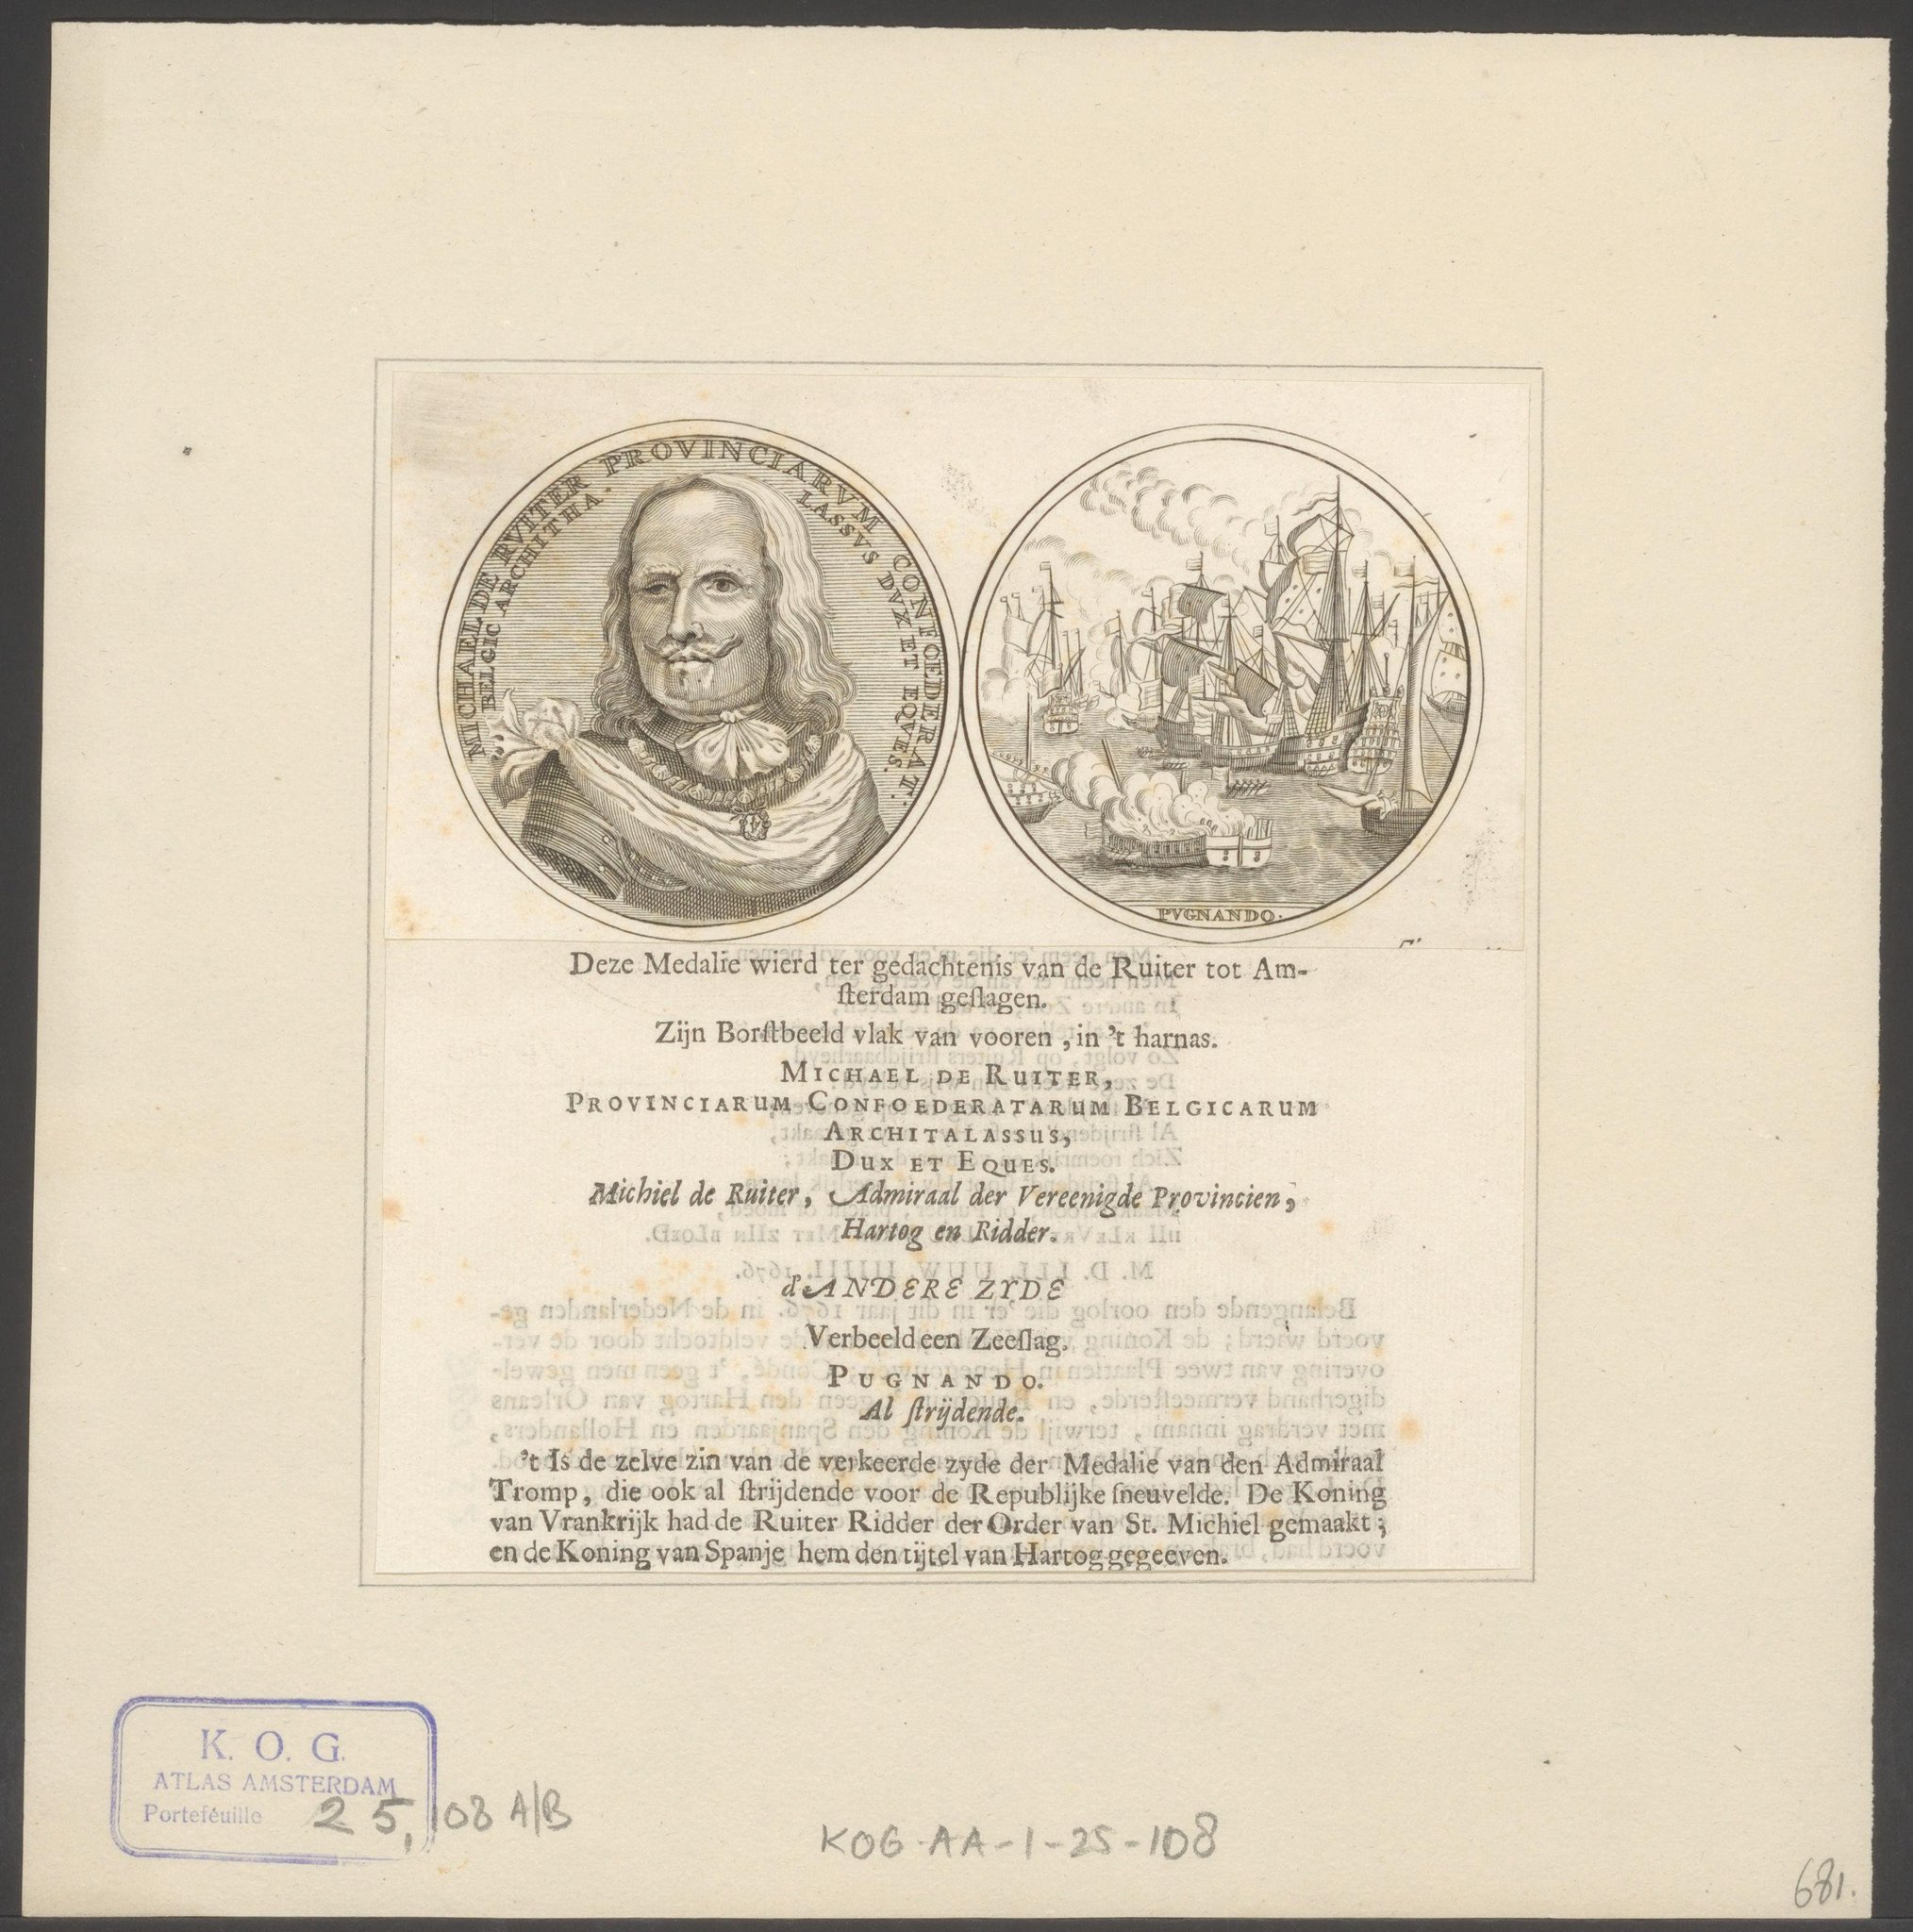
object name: text sheet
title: Voor- en achterzijde van een penning met het portret van Michiel Adriaenszoon de Ruyter en een zeeslag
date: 1690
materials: paper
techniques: engraving, letterpress printing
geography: northern netherlands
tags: michiel adriaenszoon de ruyter, war (+ naval force), memorial medal, medals and other marks of military honour, historical person (with name), amsterdam, battle of augusta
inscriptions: collector's mark: ‘25.108A/B’ Lugt 1641b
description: Met beschrijving. Nummering rechtsonder niet leesbaar: fig: 103. Onderwerpsrubriek binnen de Atlas Amsterdam: Krijgswezen I: De Admiraliteit van Amsterdam, C. Michiel Adriaensz. de Ruyter.